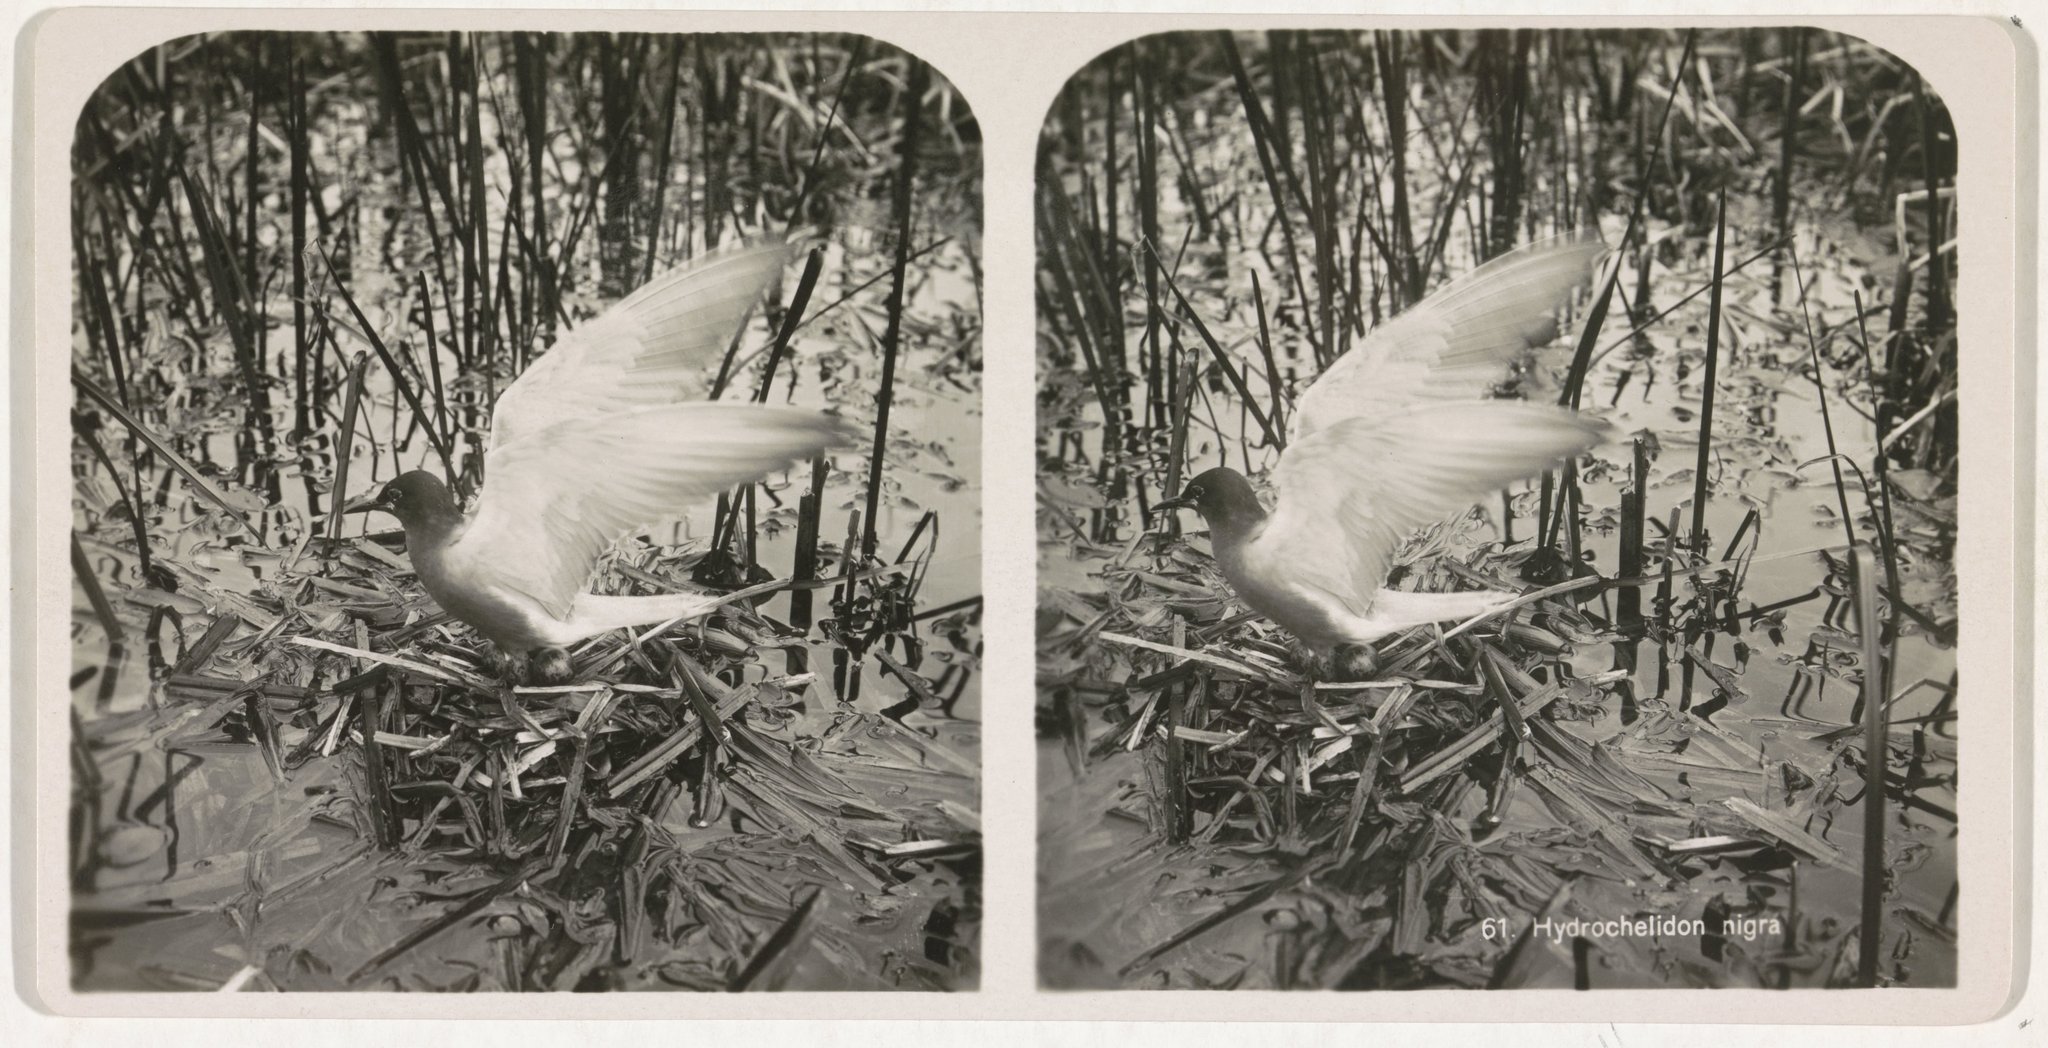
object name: stereograph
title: 61. Hydrochelidon nigra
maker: adolphe burdet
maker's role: fotograaf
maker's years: 1860-1940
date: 1870-1940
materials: photographic support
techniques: gelatin silver print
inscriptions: label: ‘Zee-Zwaluw’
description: De foto is afkomstig uit een serie van 12 stereofoto's met moerasvogels die bewaard worden in het originele mapje. Bij dit mapje zit ook een blaadje met gedrukte tekst over de vogels.